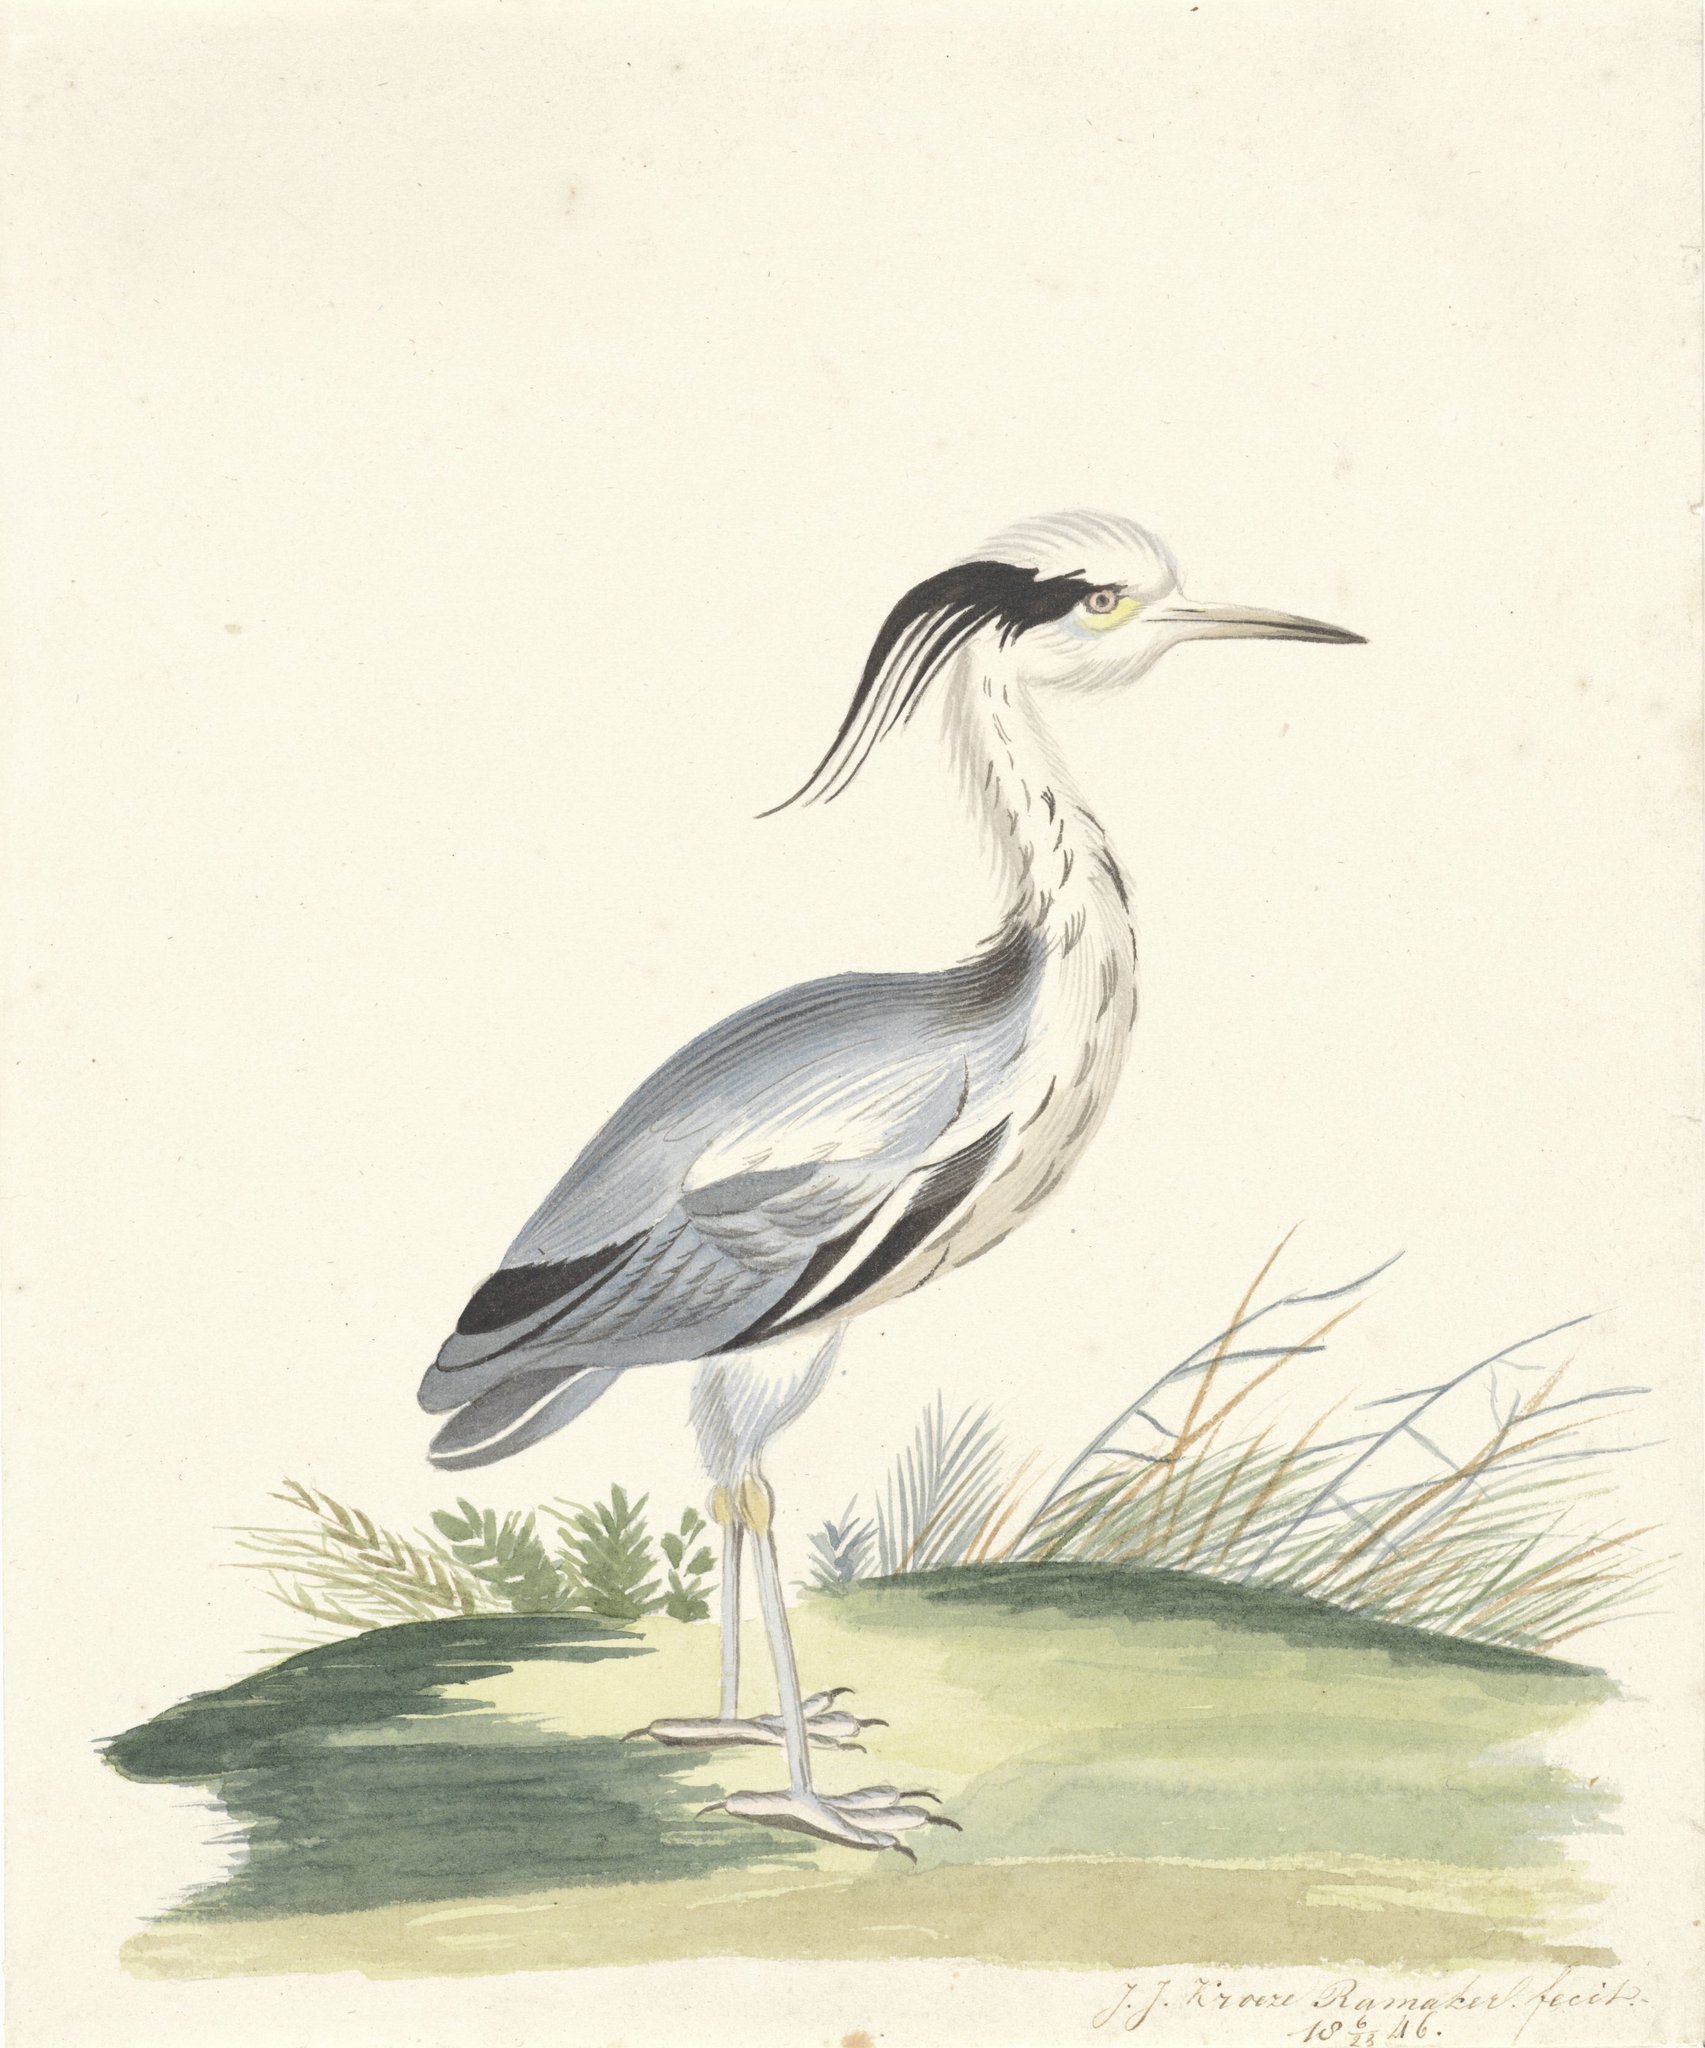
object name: drawing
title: Zilverreiger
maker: j.j. ramaker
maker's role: draughtsman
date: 1846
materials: paper, pencil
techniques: brush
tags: shore-birds and wading-birds: grey heron